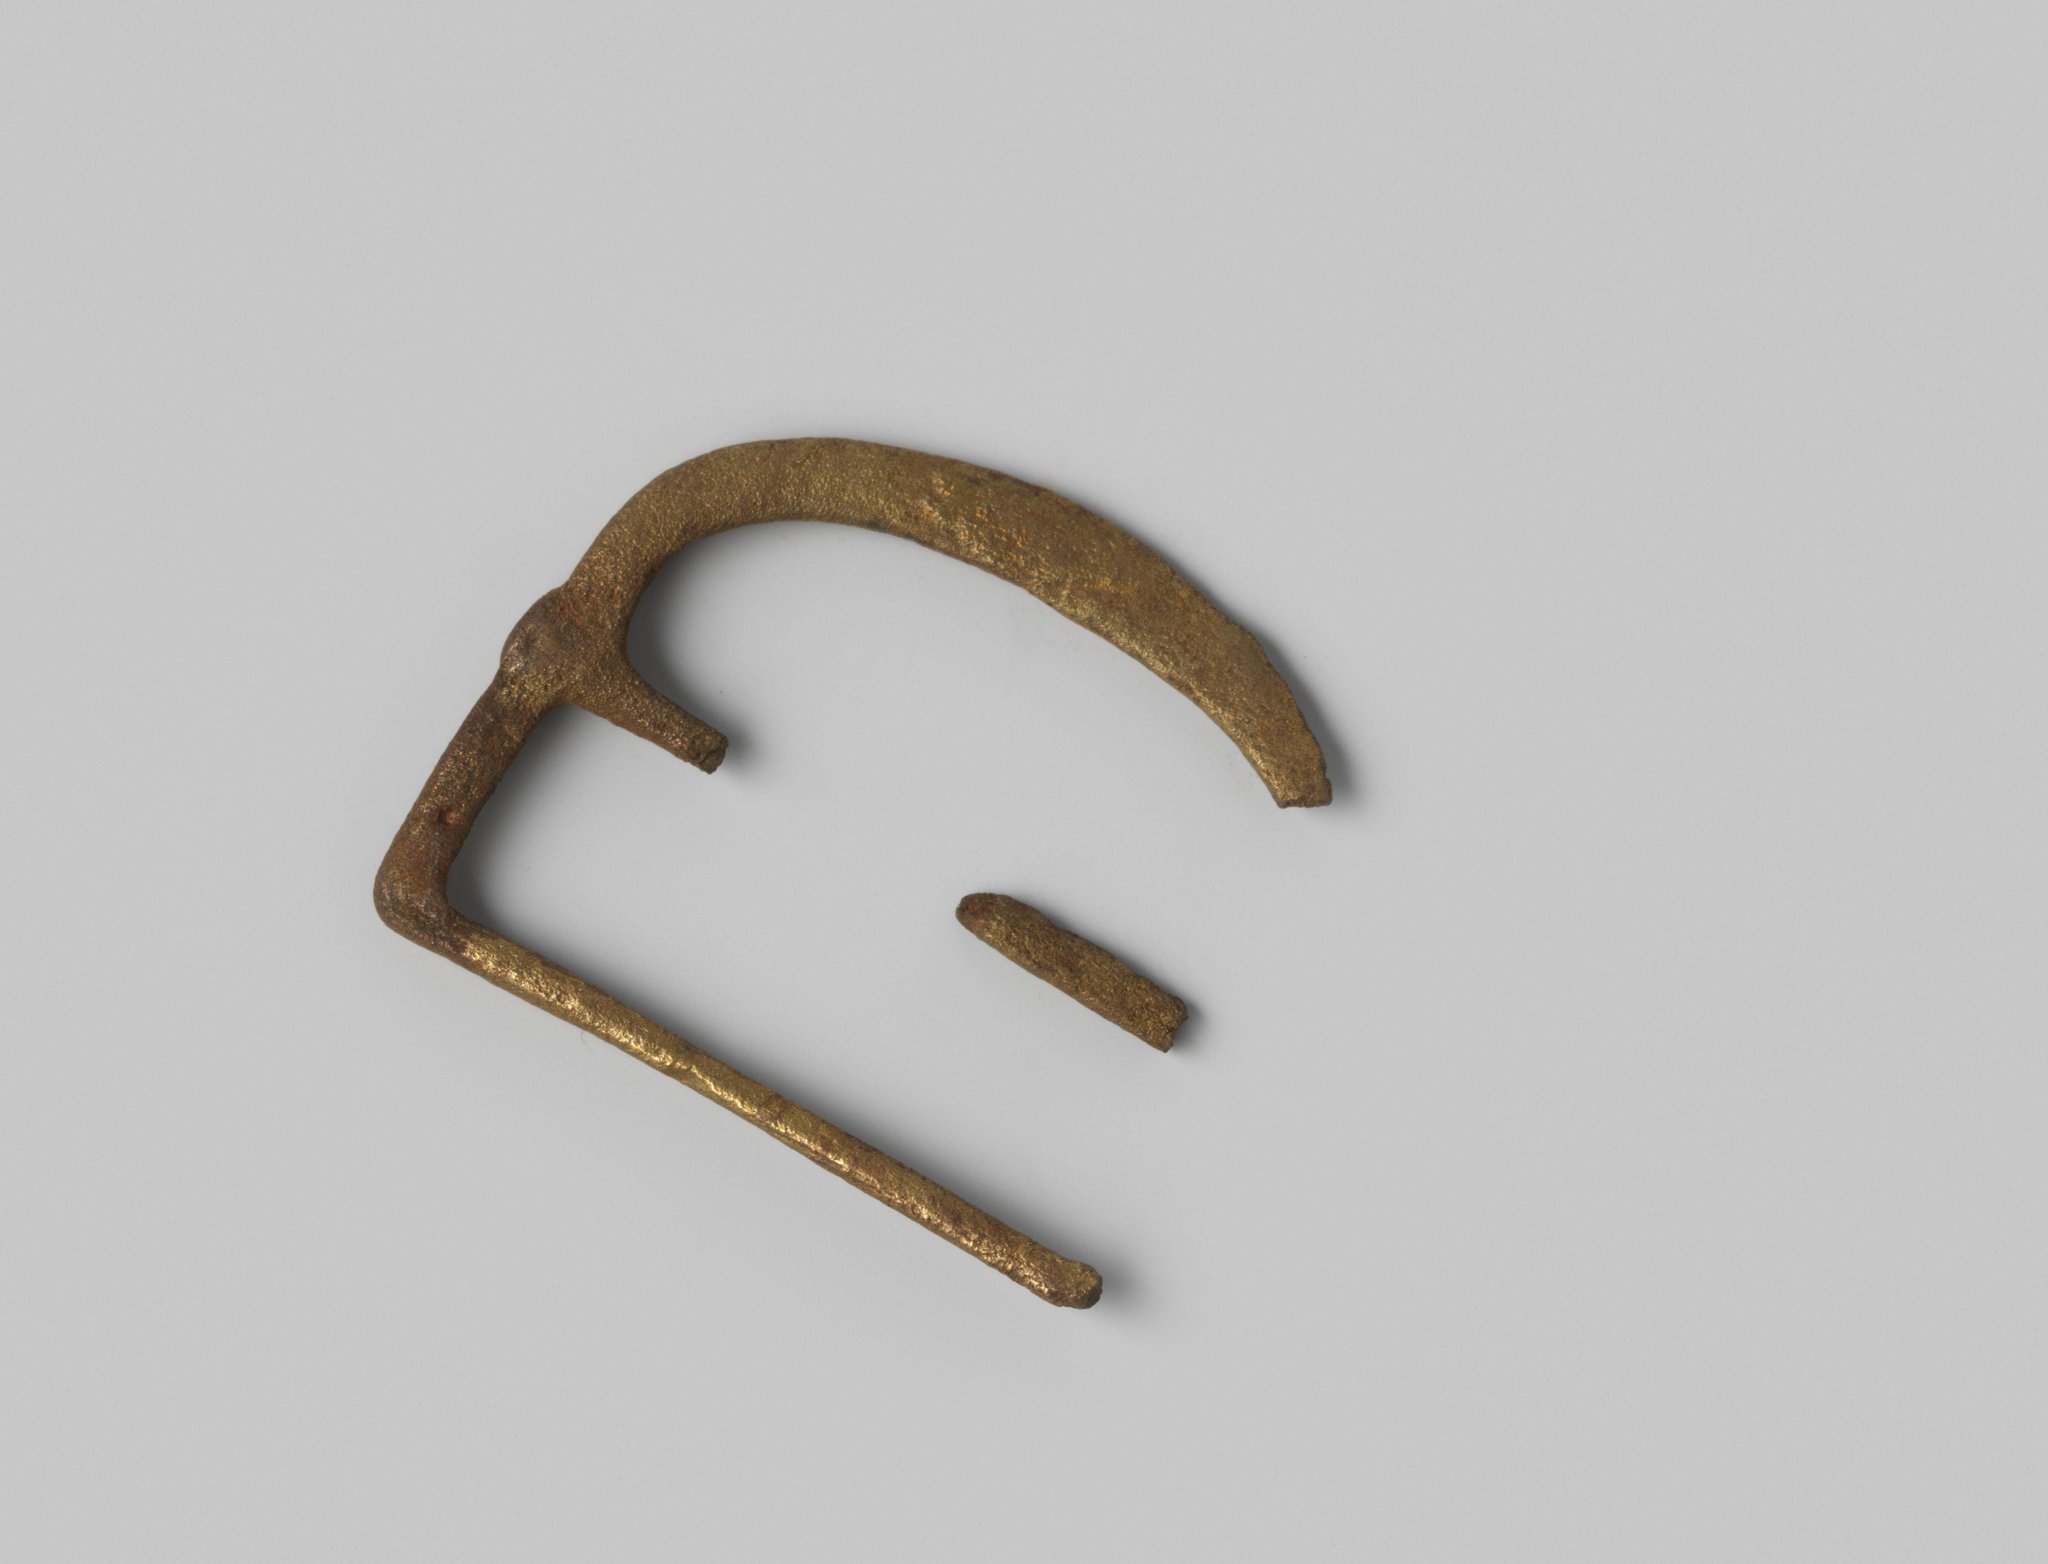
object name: belt buckle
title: Fragmenten riemgesp uit het wrak van de Oost-Indiëvaarder Hollandia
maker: Anonymous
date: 1700-1743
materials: copper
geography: netherlands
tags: verenigde oostindische compagnie, hollandia (schip), annet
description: D-shaped, fragm ring, id. NG 1979-182H2177, belt buckle.